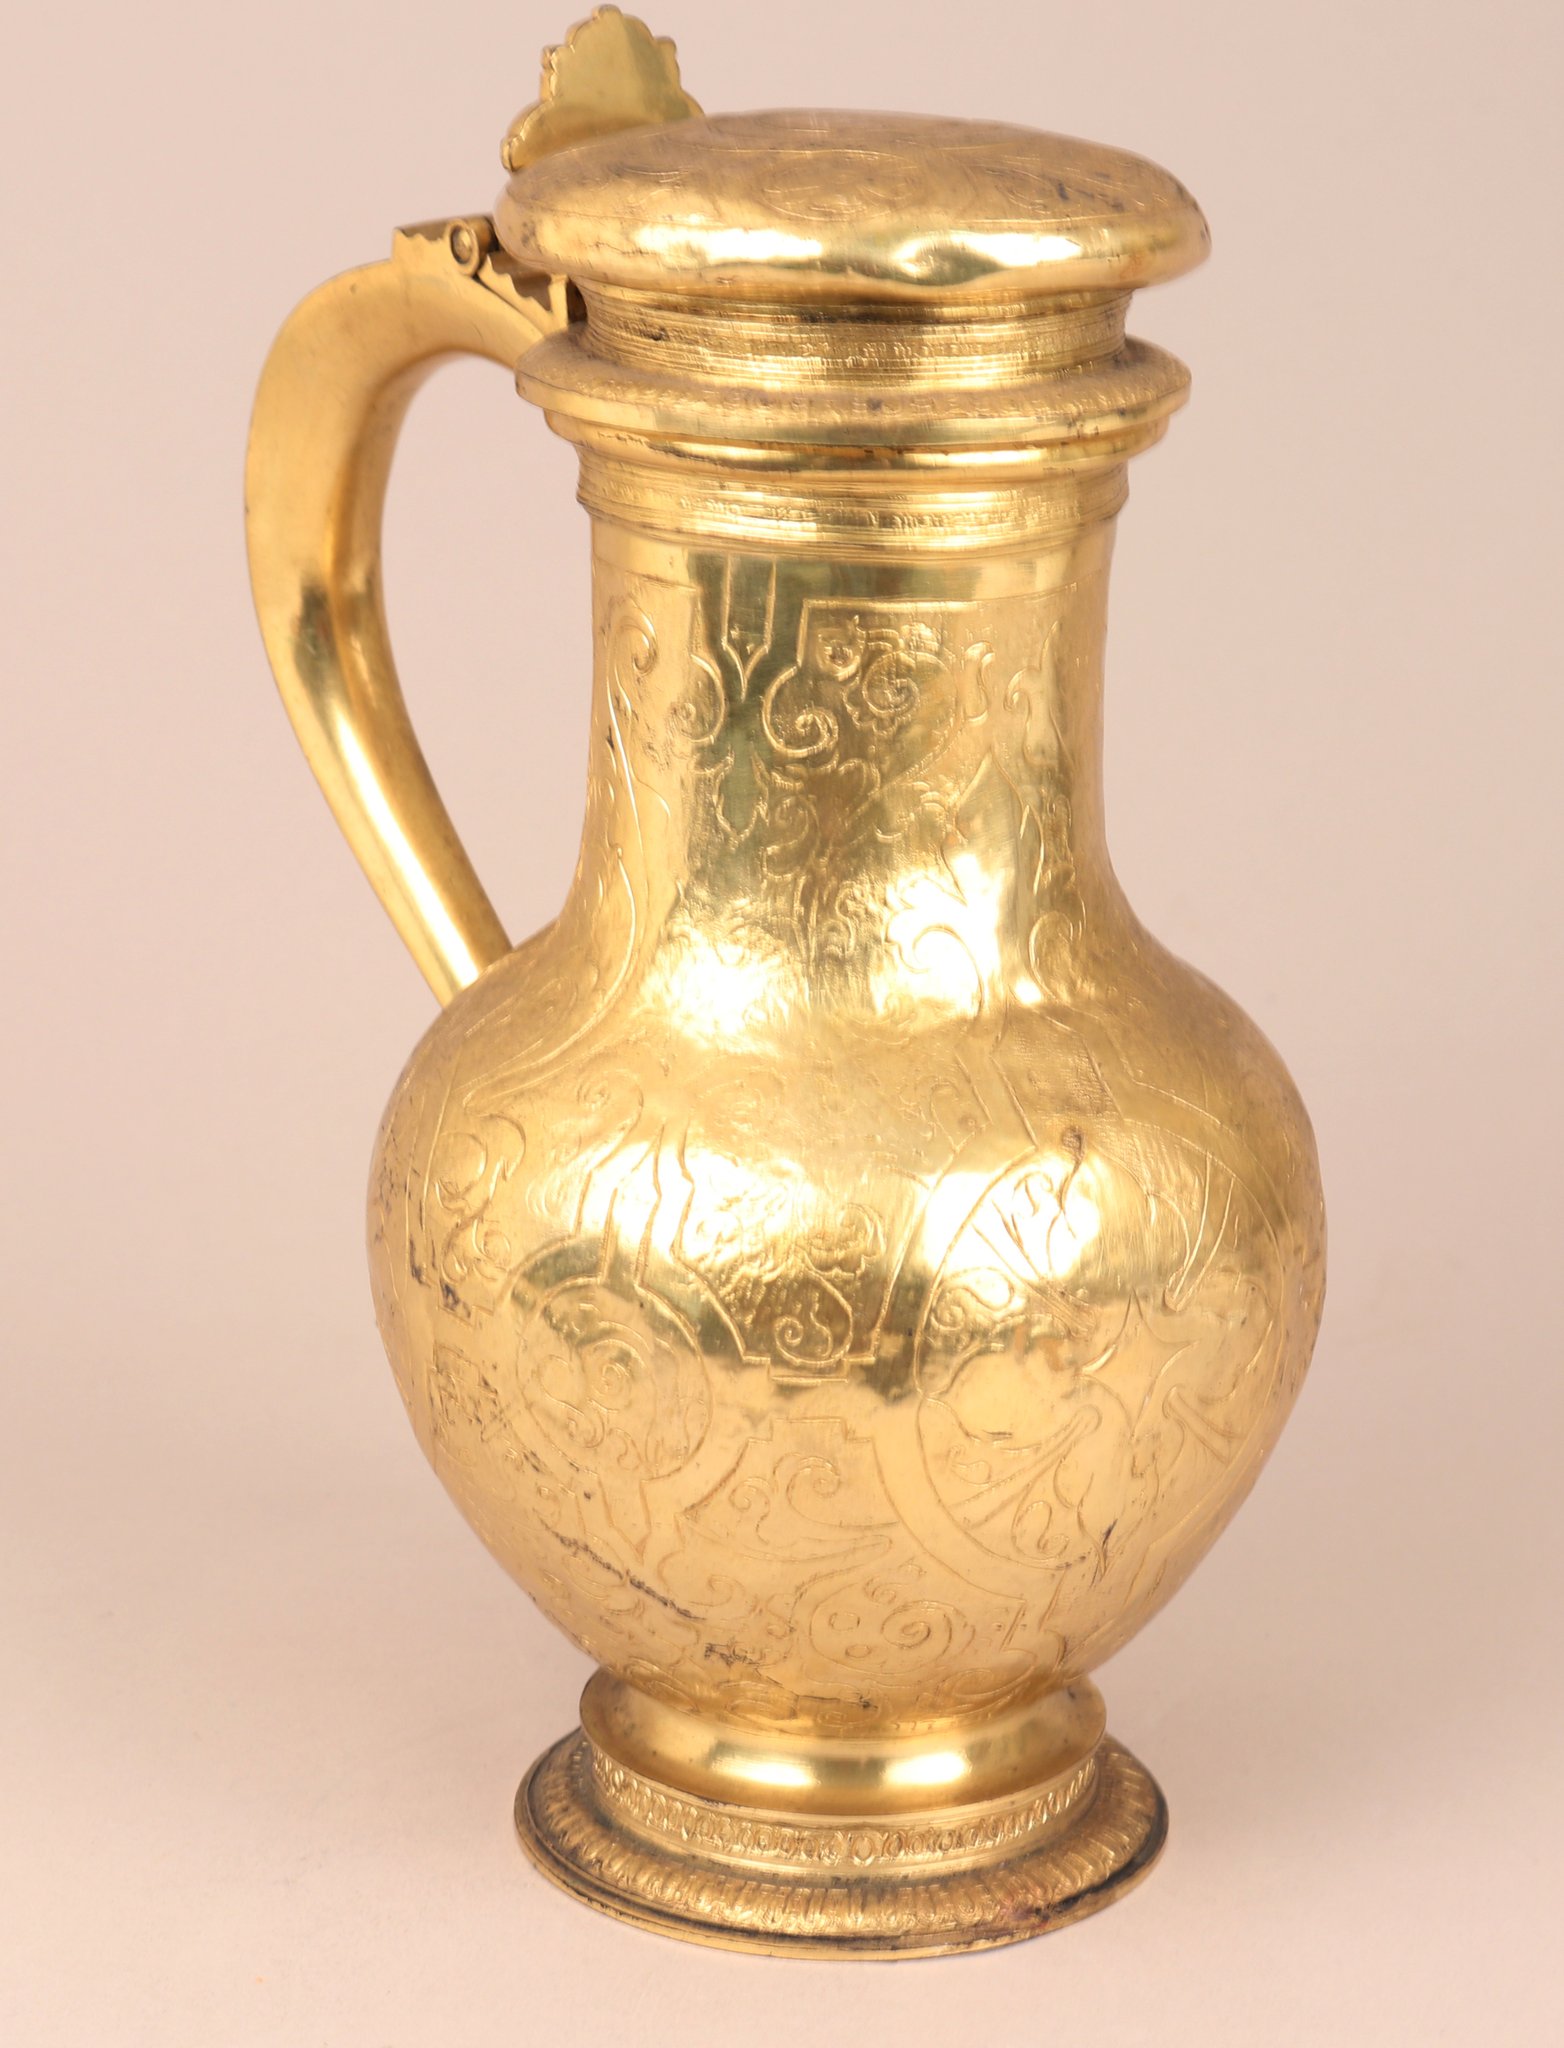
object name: flagon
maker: elkington & co.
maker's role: manufacturer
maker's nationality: british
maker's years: 1829-1963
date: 1801-1900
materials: metal, silver